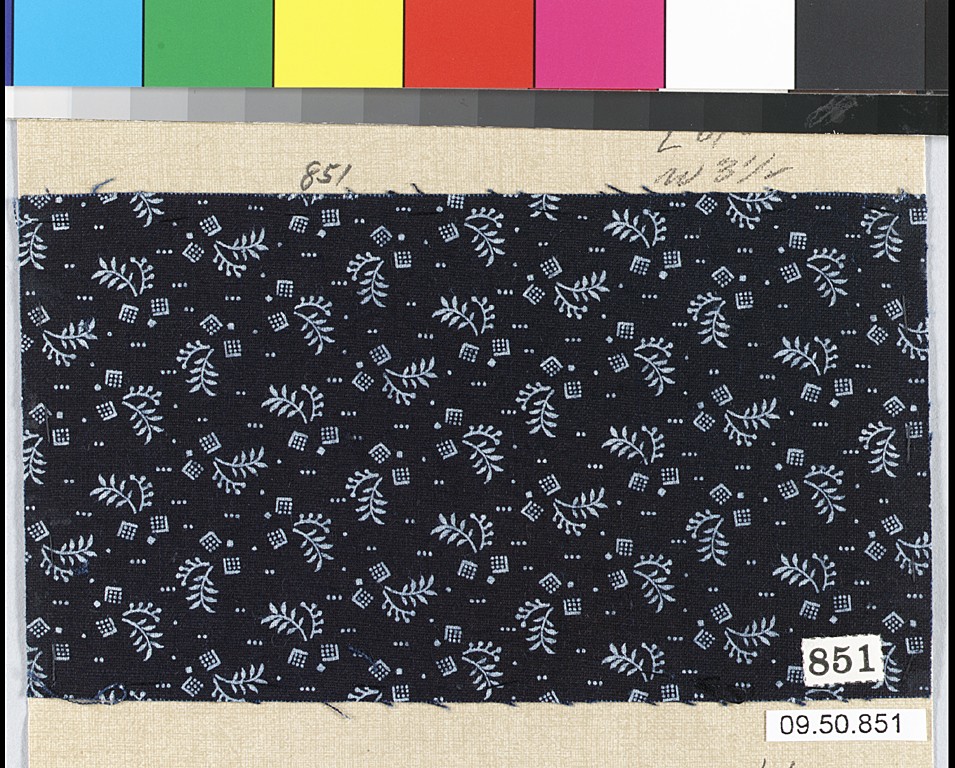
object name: piece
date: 1801-1900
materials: cotton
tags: leaves